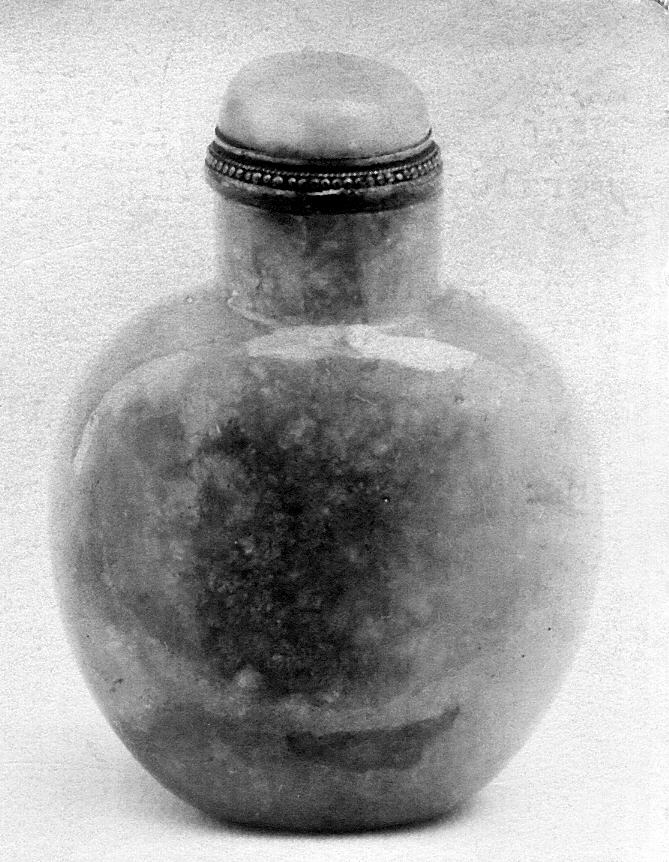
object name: snuff bottle with stopper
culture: chinese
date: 1801-1900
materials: jade